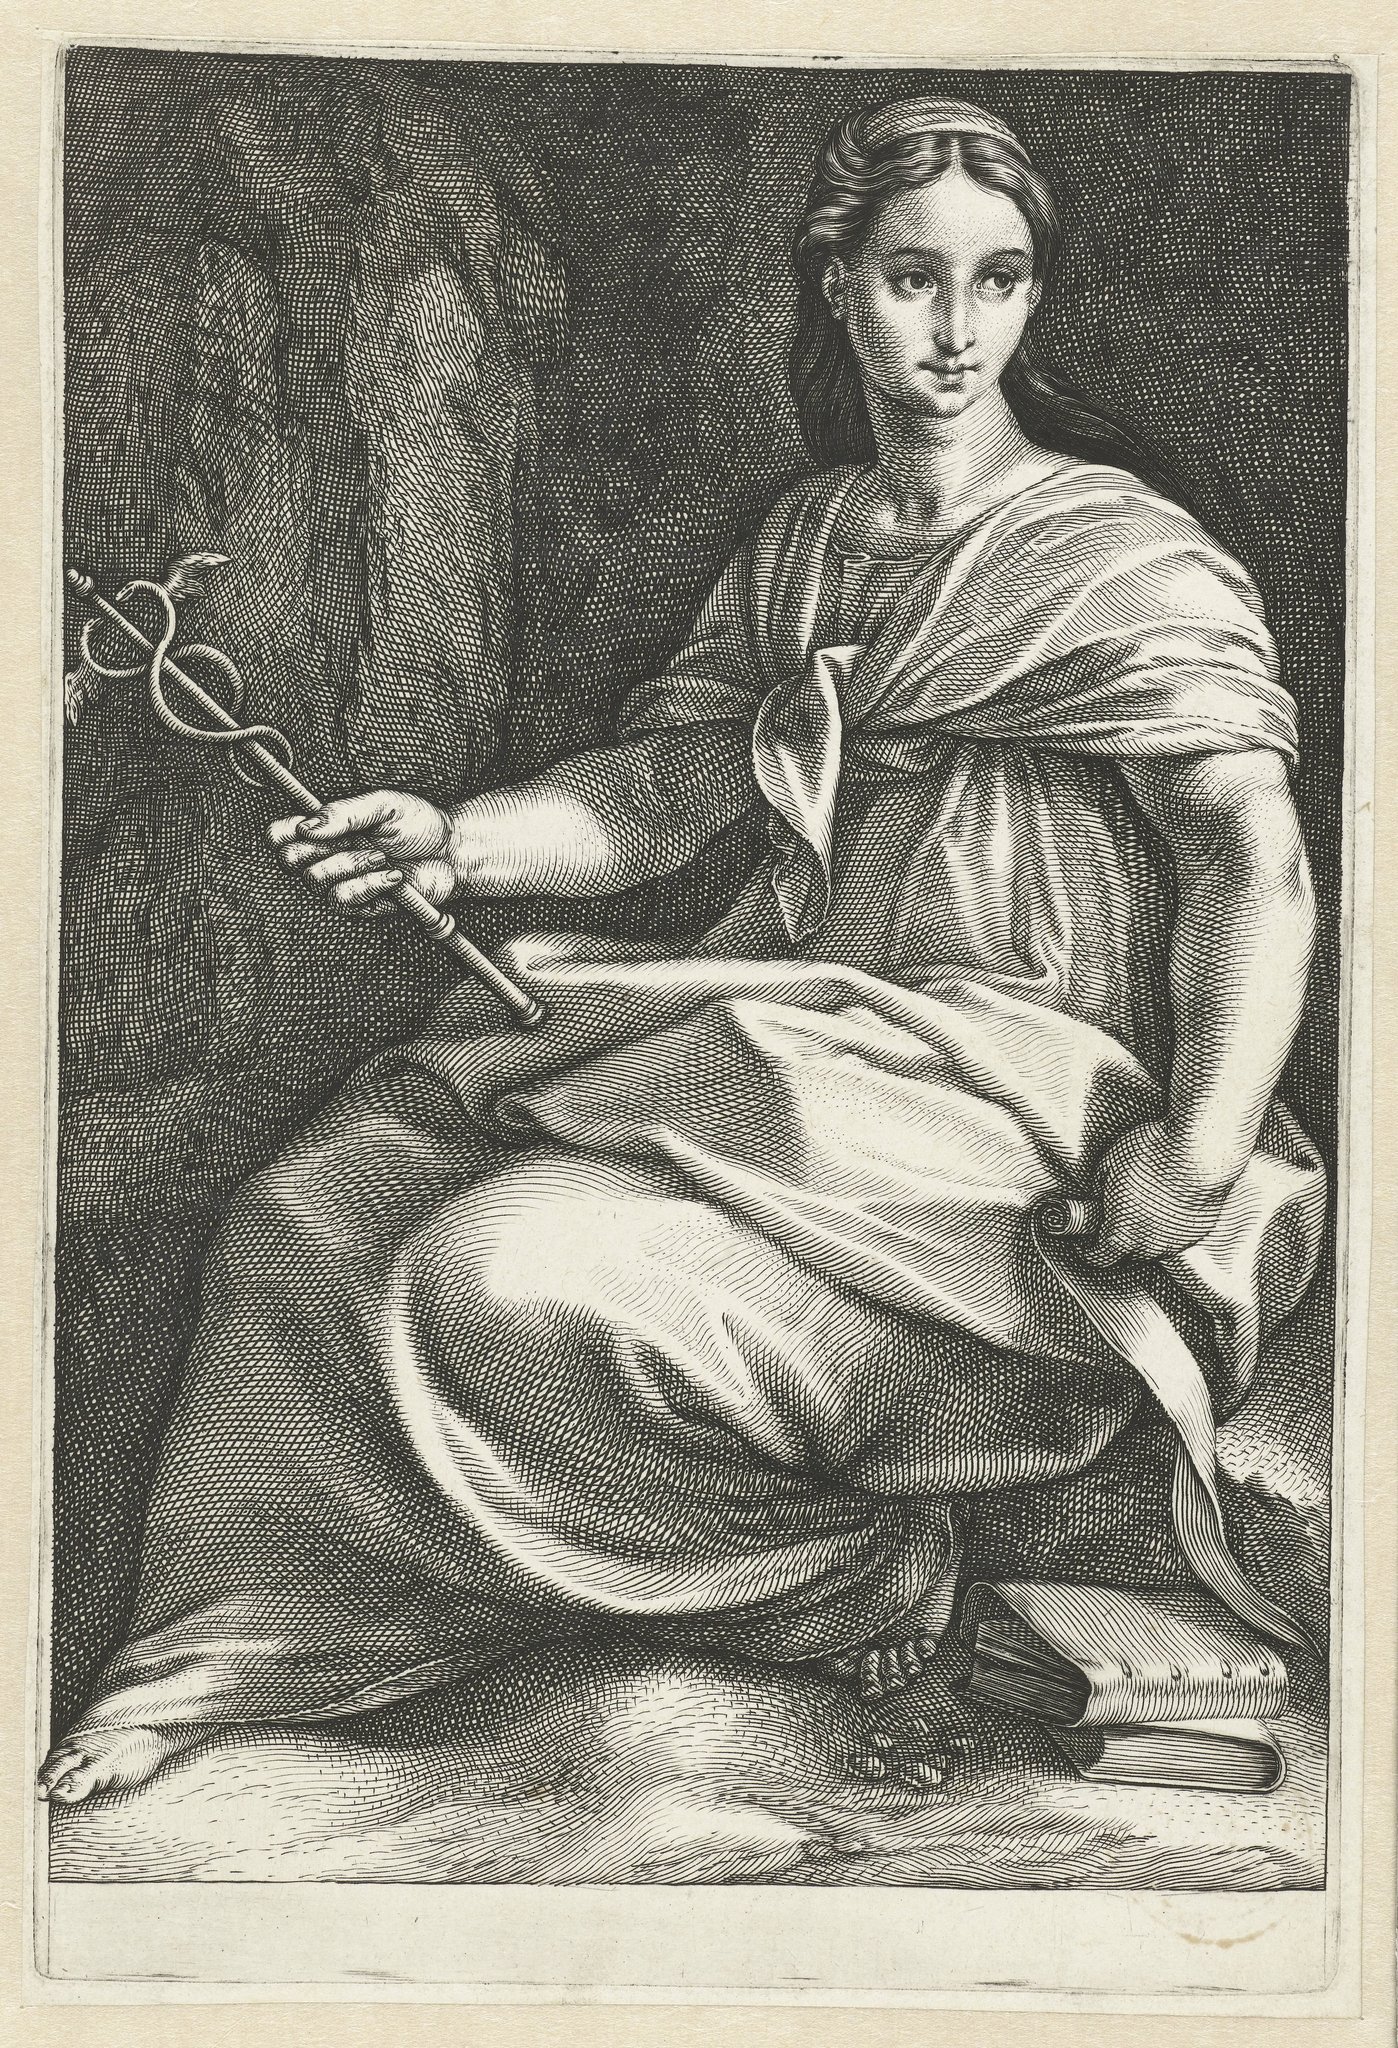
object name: print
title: Polyhymnia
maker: hendrick goltzius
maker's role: draughtsman, painter, print maker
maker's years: 1558-1617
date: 1592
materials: paper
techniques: engraving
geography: haarlem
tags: polyhymnia (one of the muses); 'polinnia' (ripa)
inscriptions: collector's mark: Lugt 240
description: Een serie van negen muzen. Eerste staat, voor onderschriften.